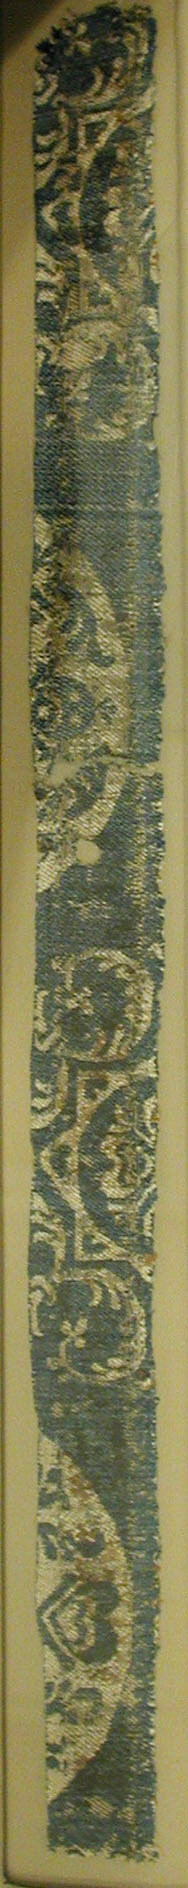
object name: textile fragment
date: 401-500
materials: linen, silk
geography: iran